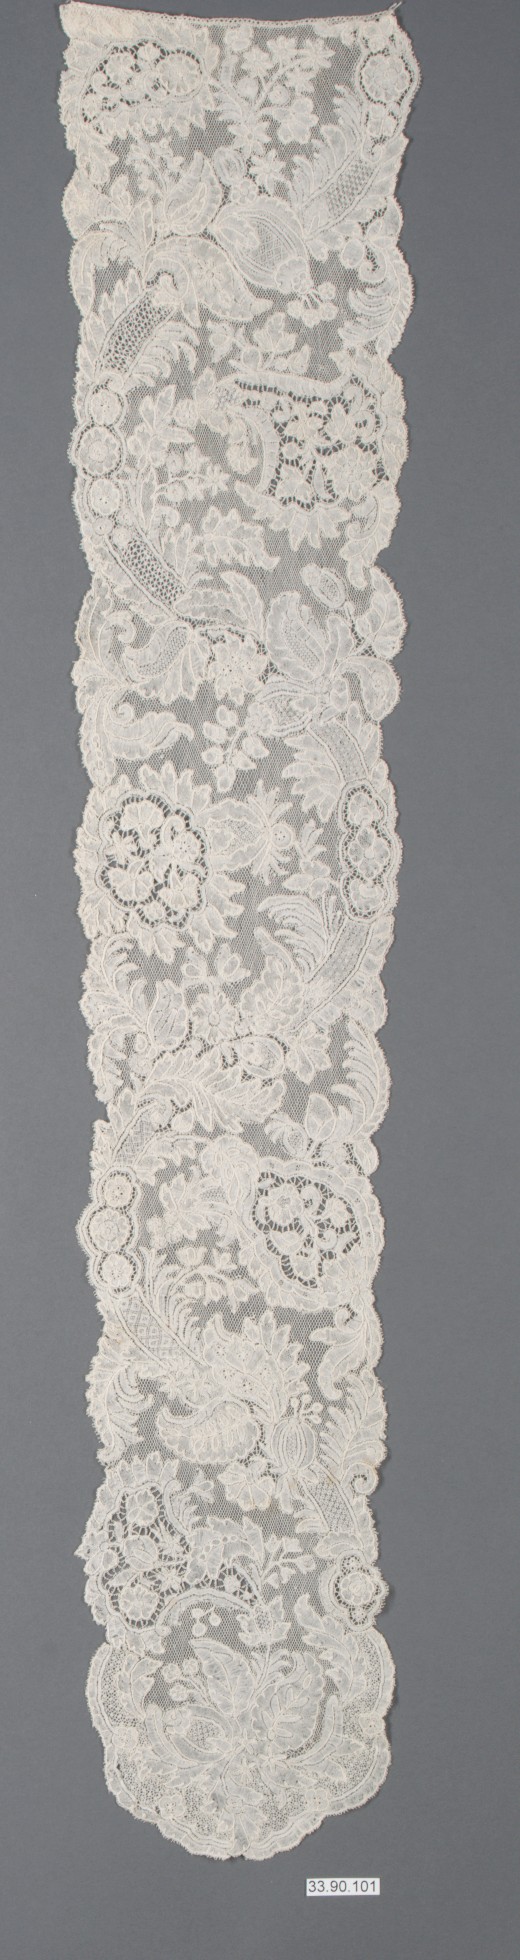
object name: lappet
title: Lappet (one of a pair)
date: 1734-1766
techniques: lace